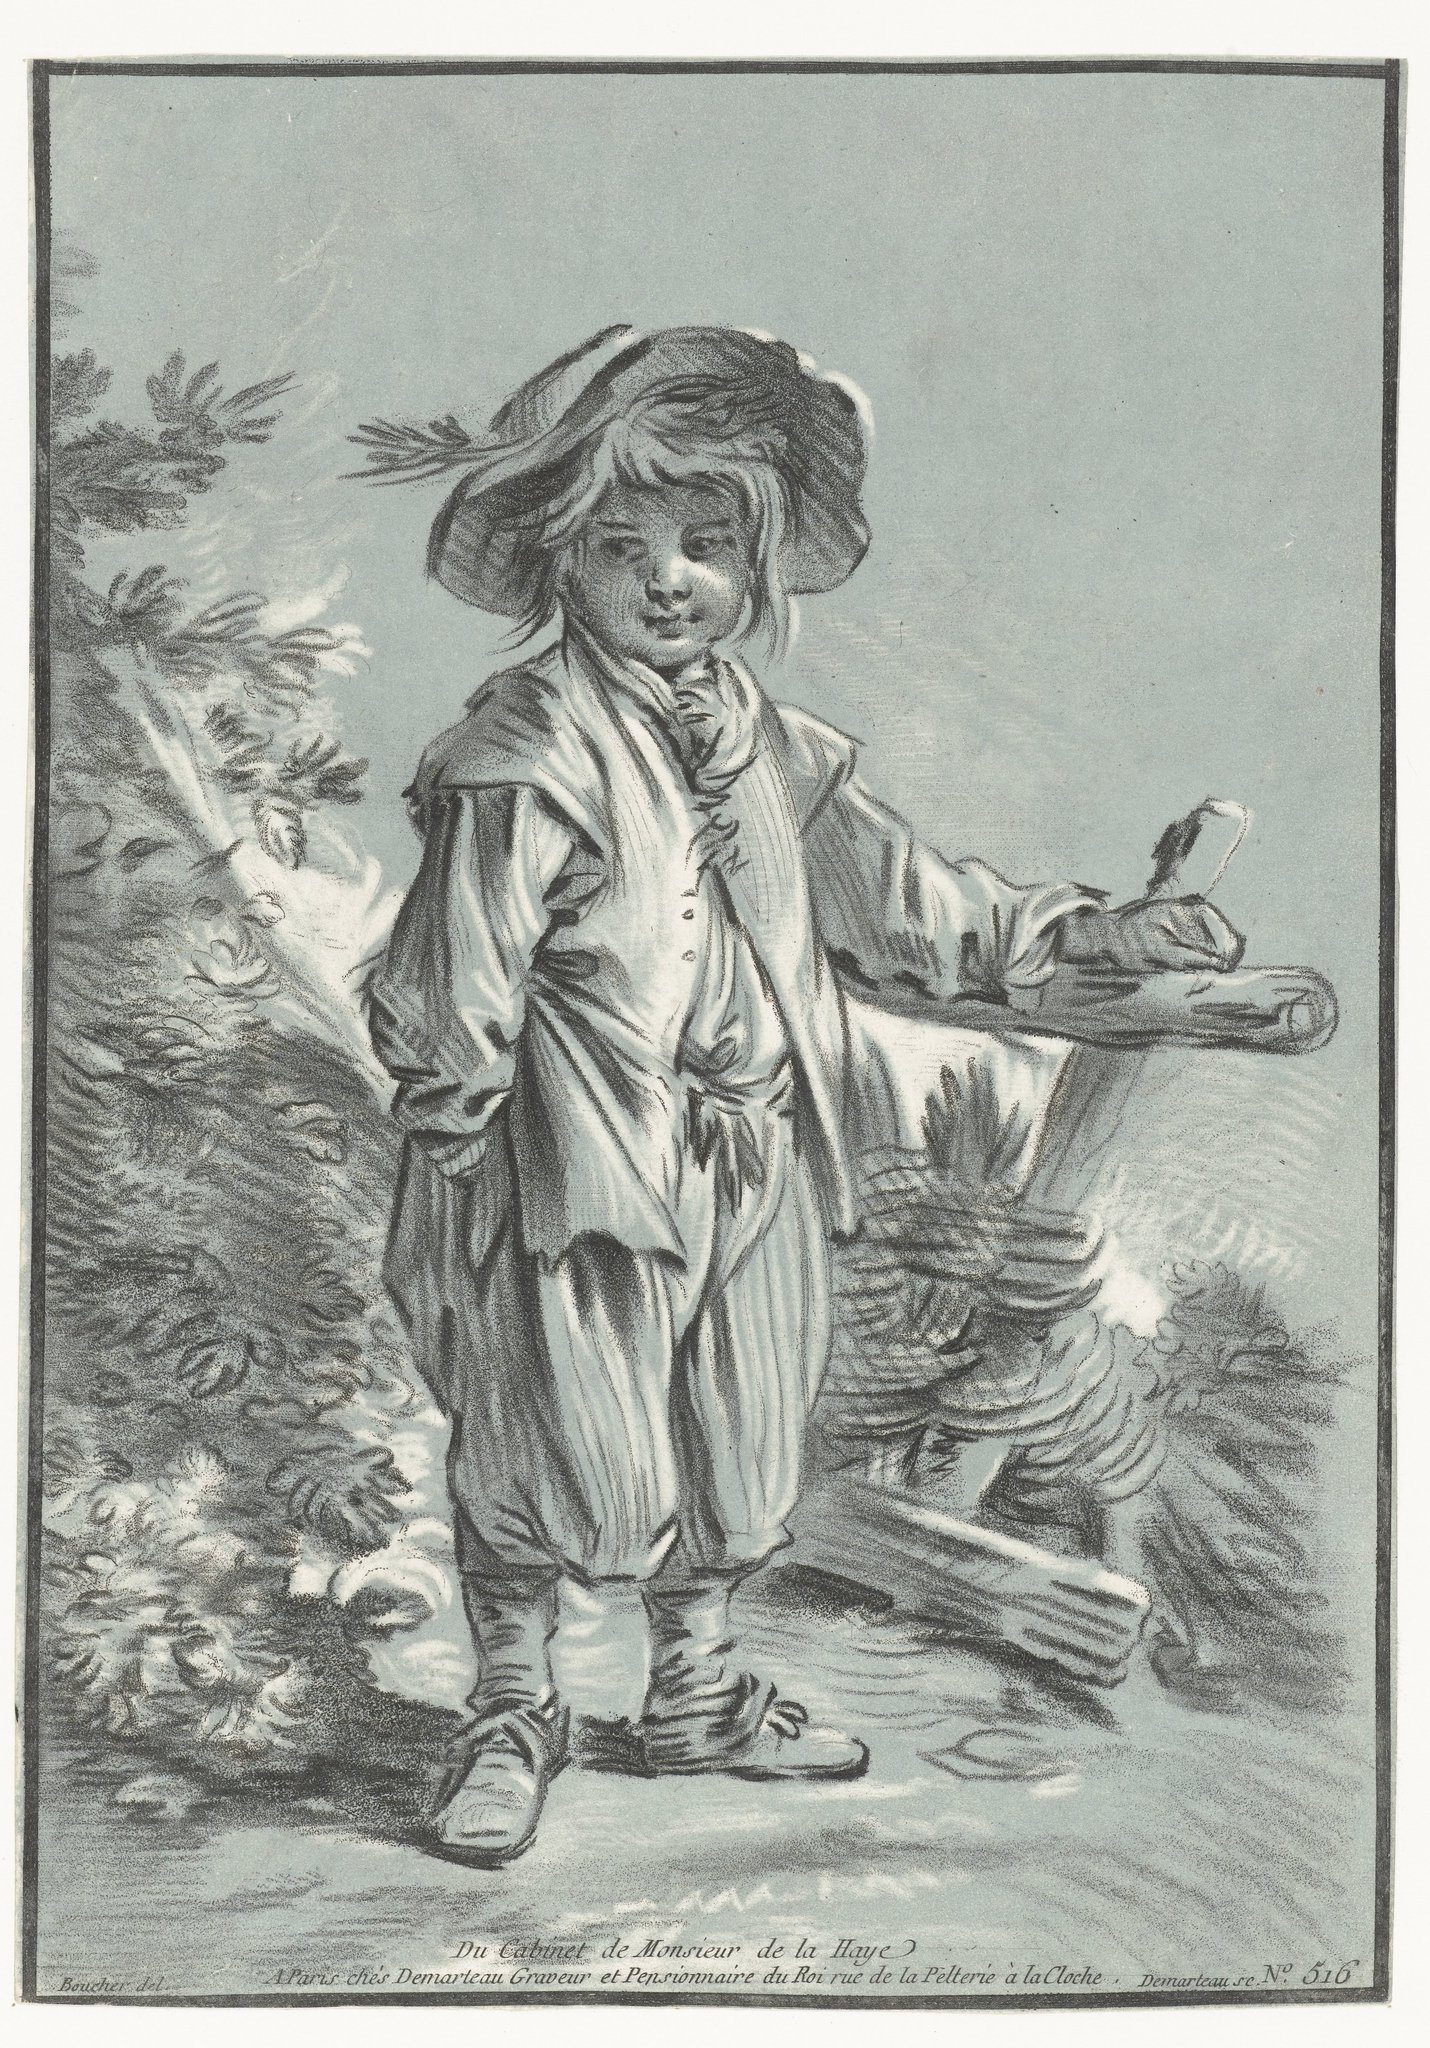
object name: print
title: Un polisson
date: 1756-1776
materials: paper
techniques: printing, printmaking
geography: paris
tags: child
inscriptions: collector's mark: Lugt 2233, number: ‘No. 516’, inscription: ‘Du Cabinet de Monsieur de la Haye’